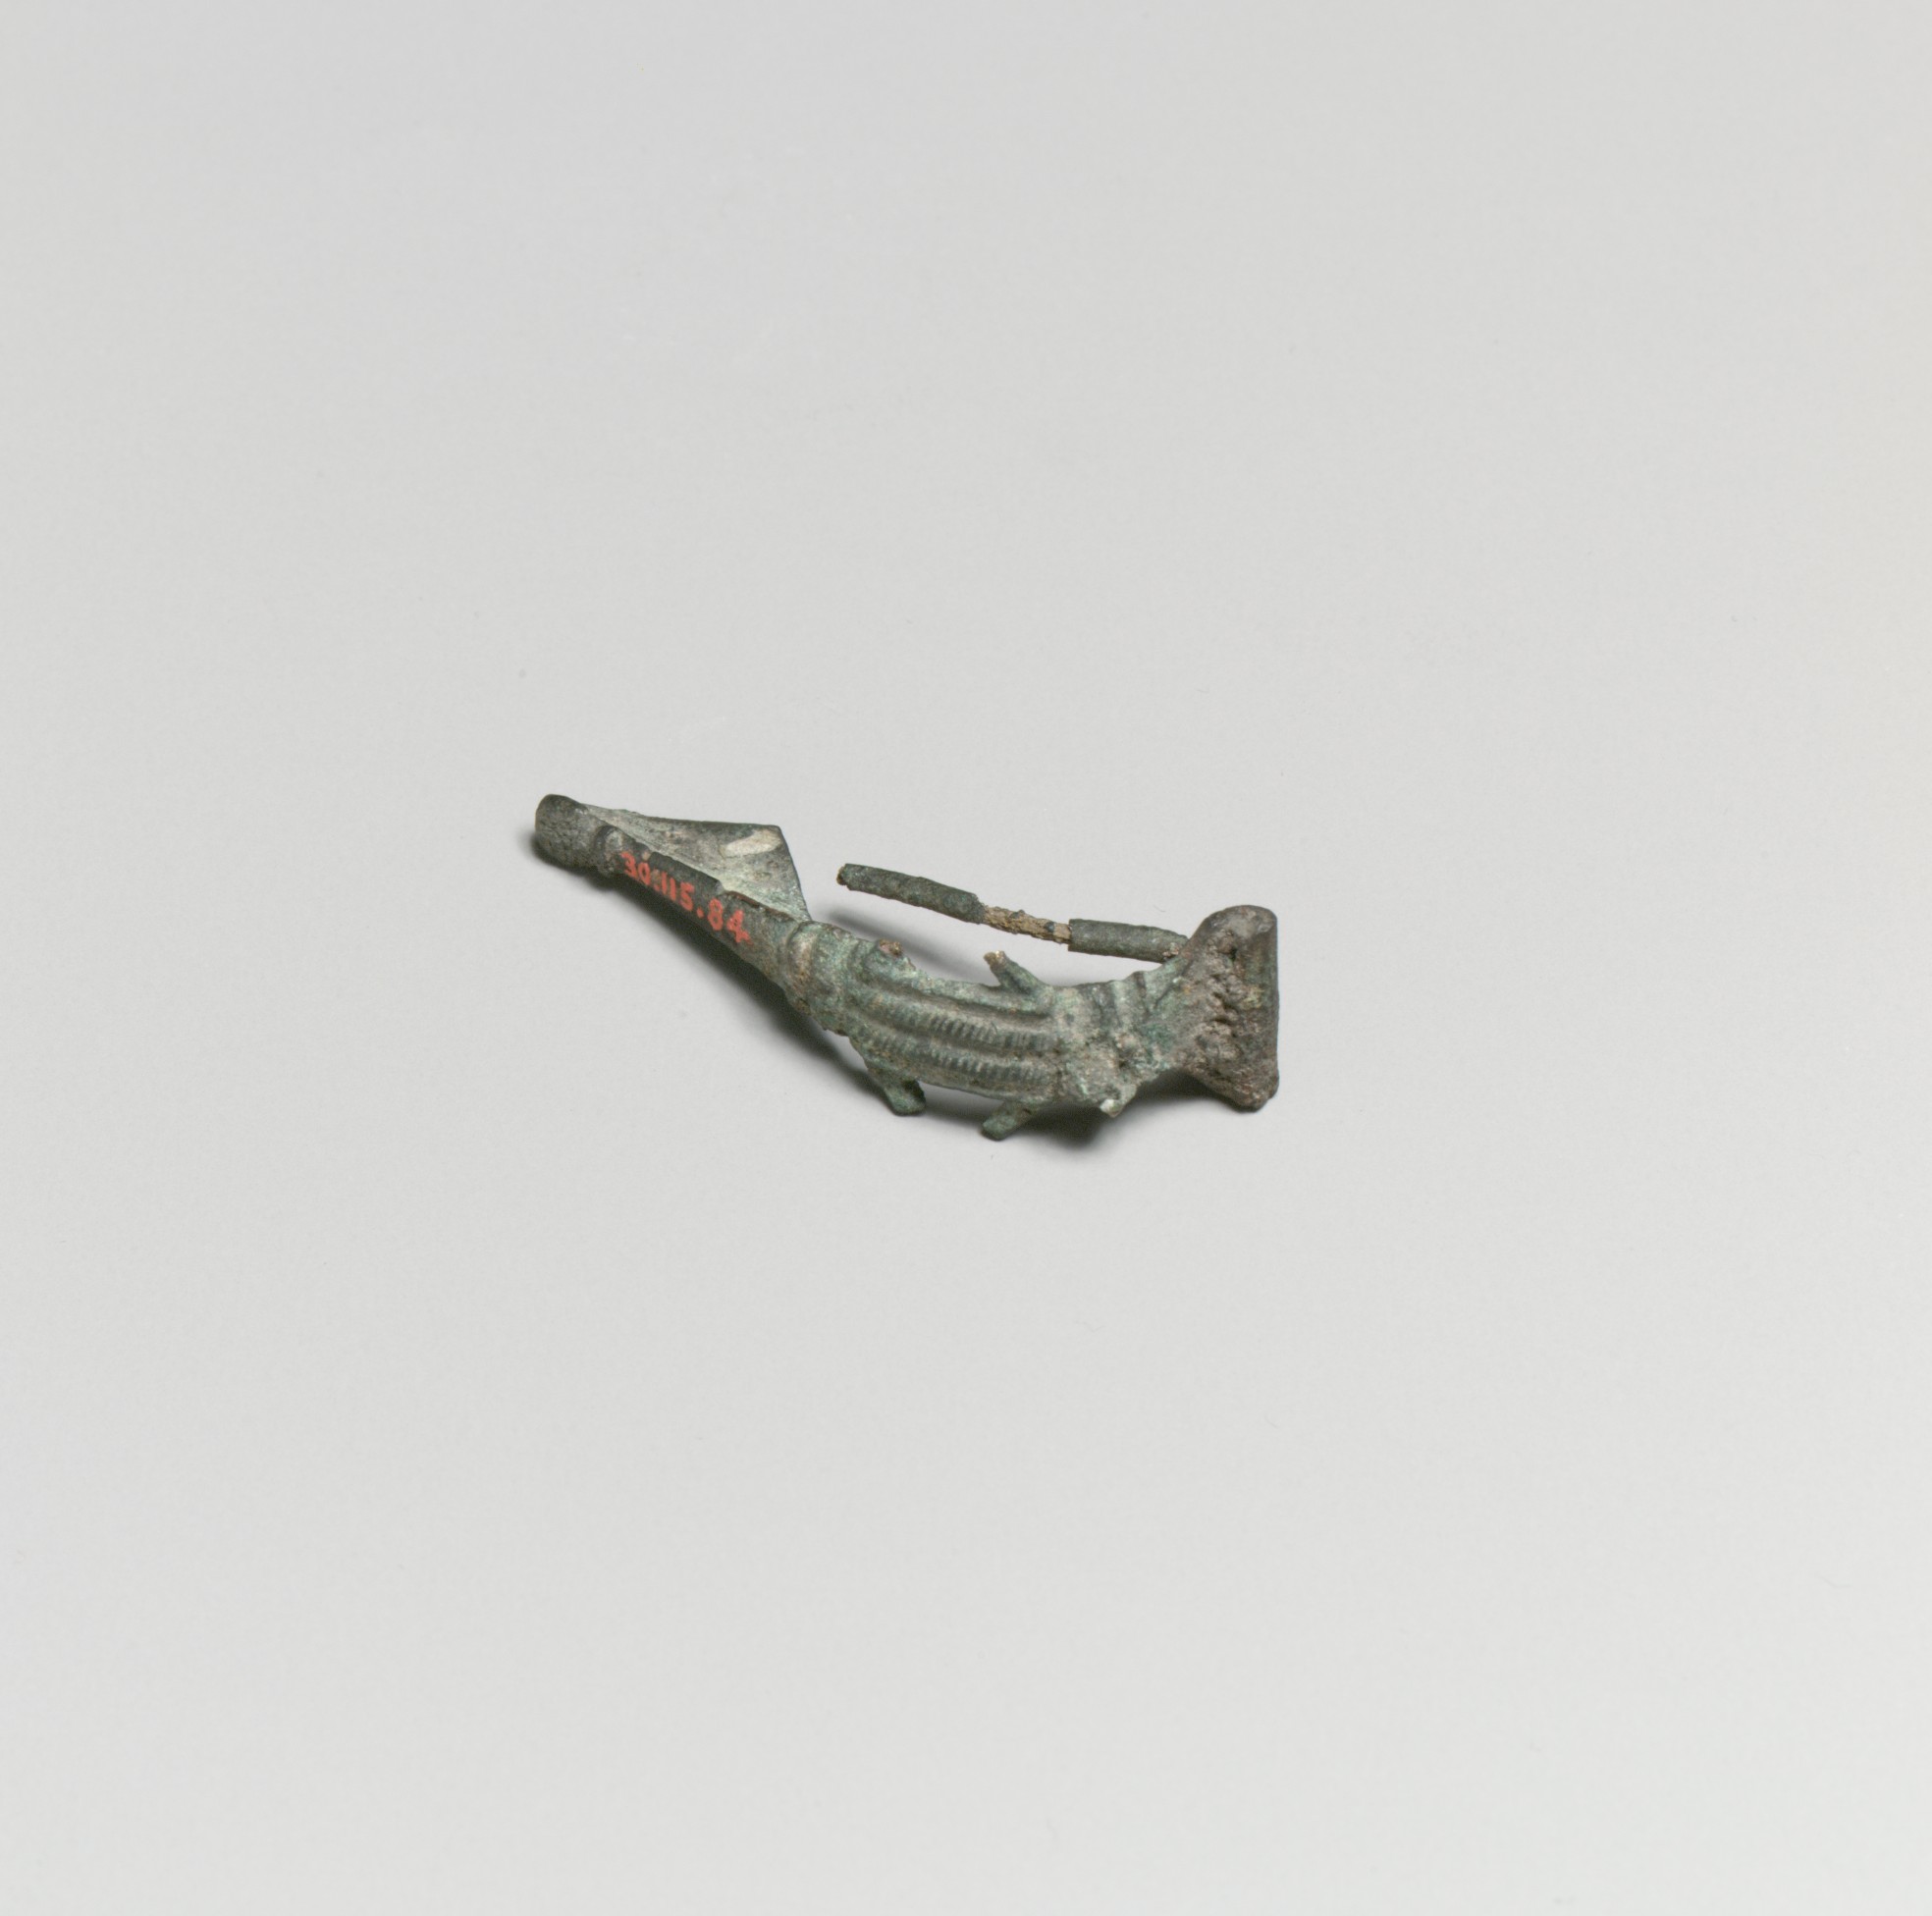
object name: fibula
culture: roman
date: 670 BCE-330 CE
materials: bronze